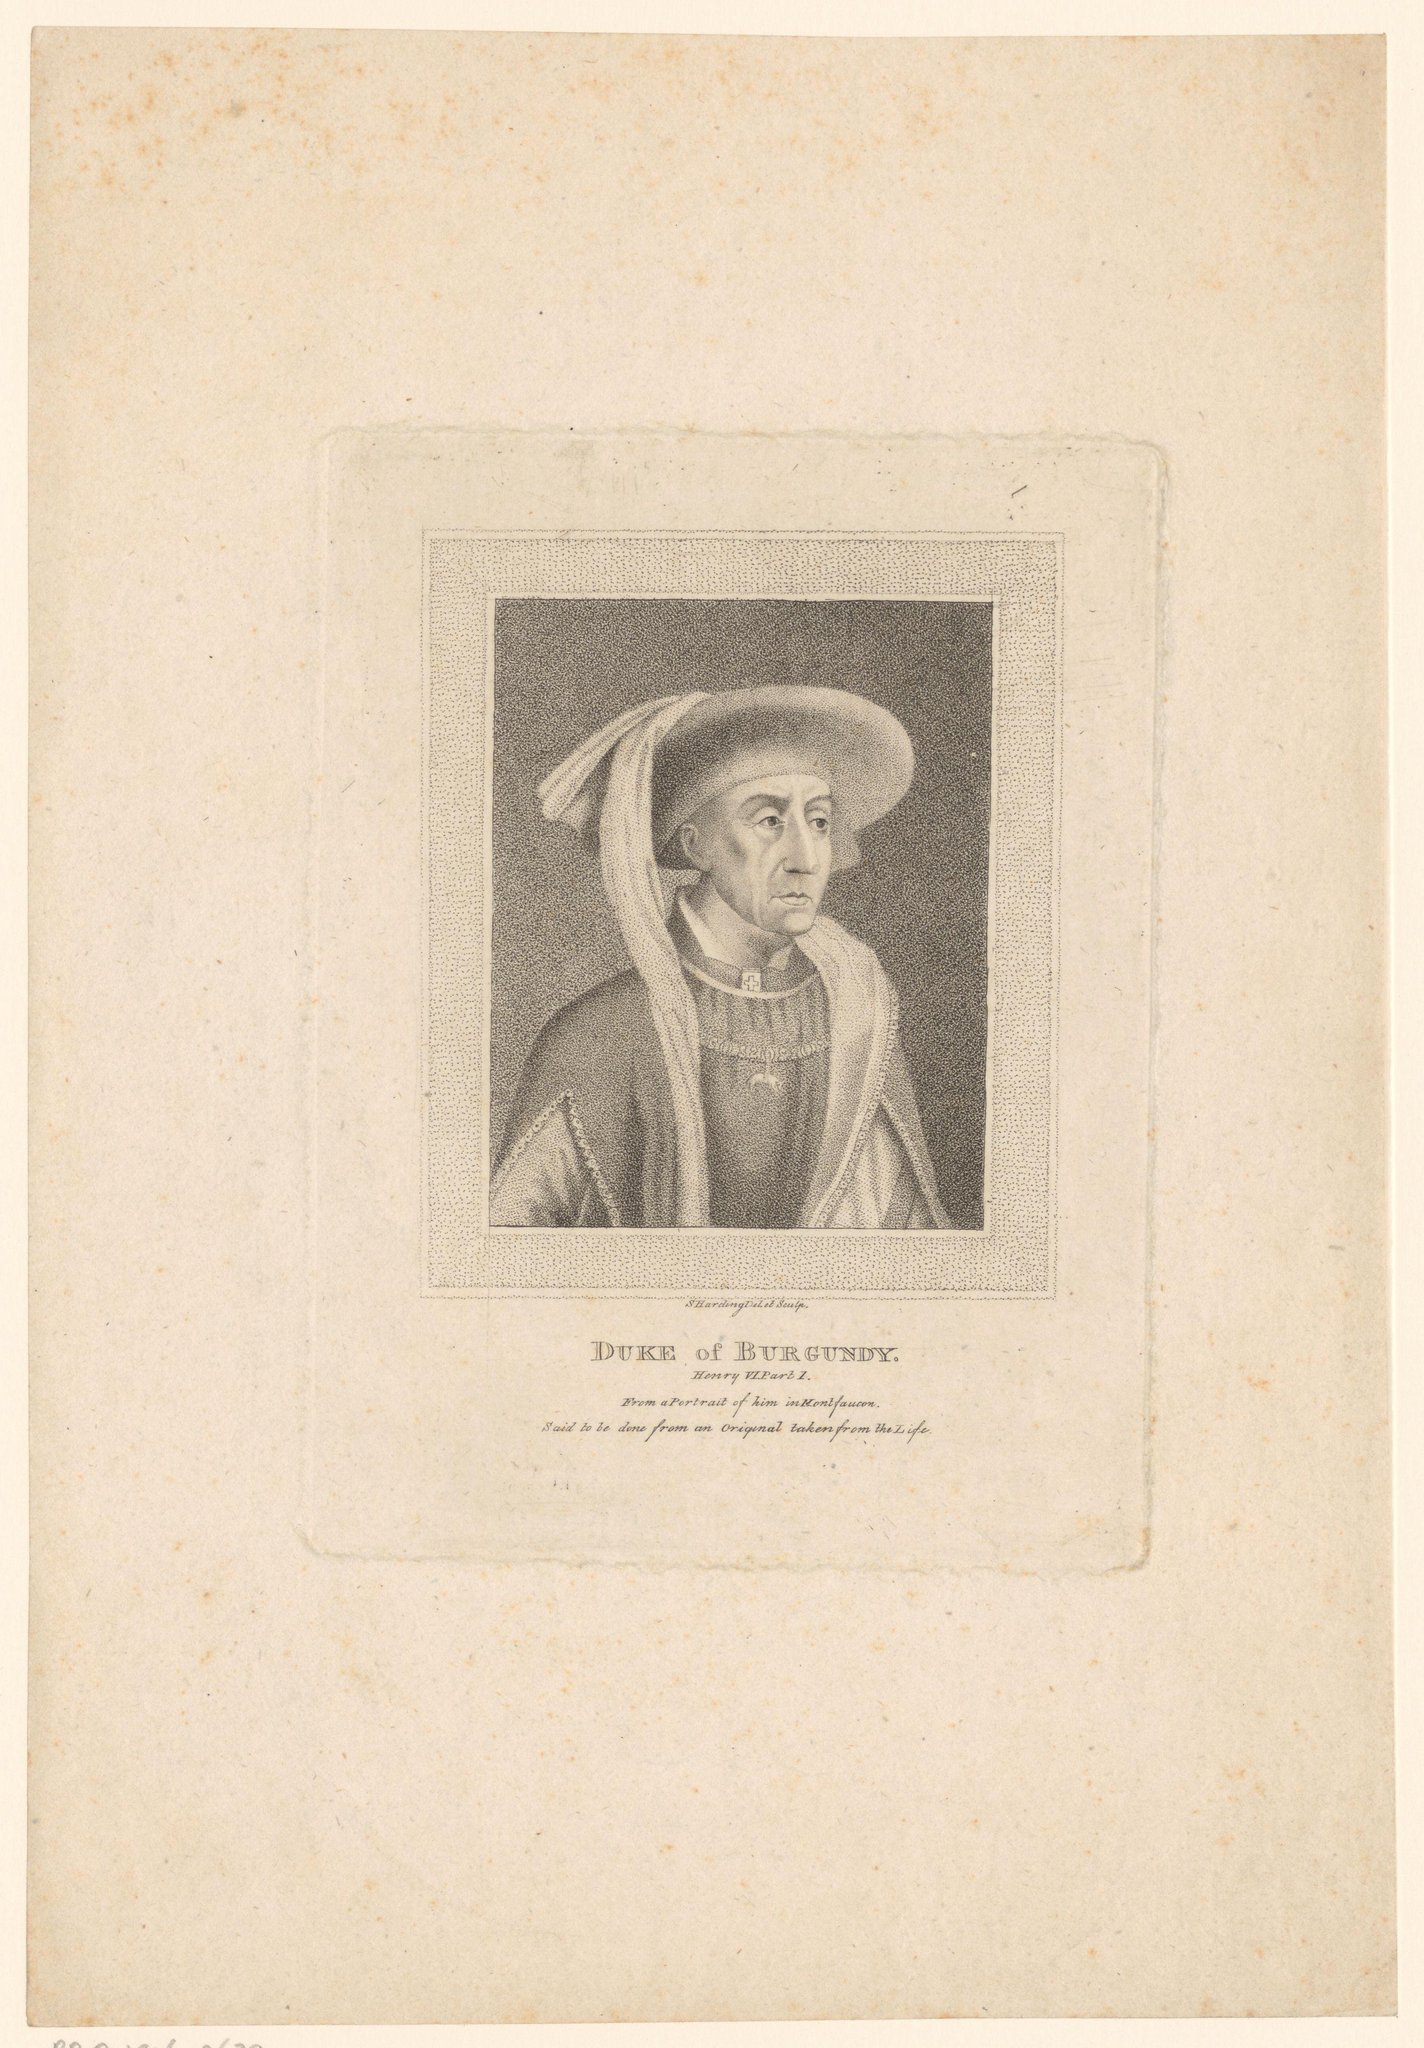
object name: print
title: Duke of Burgundy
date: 1793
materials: paper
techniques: etching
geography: london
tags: william shakespeare, philip iii the good, historical persons, knighthood order of the golden fleece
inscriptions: collector's mark: Lugt 2228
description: Prent uit: Shak[e]speare Illustrated (...). Londen: Sylvester en Edward Harding, 1793.